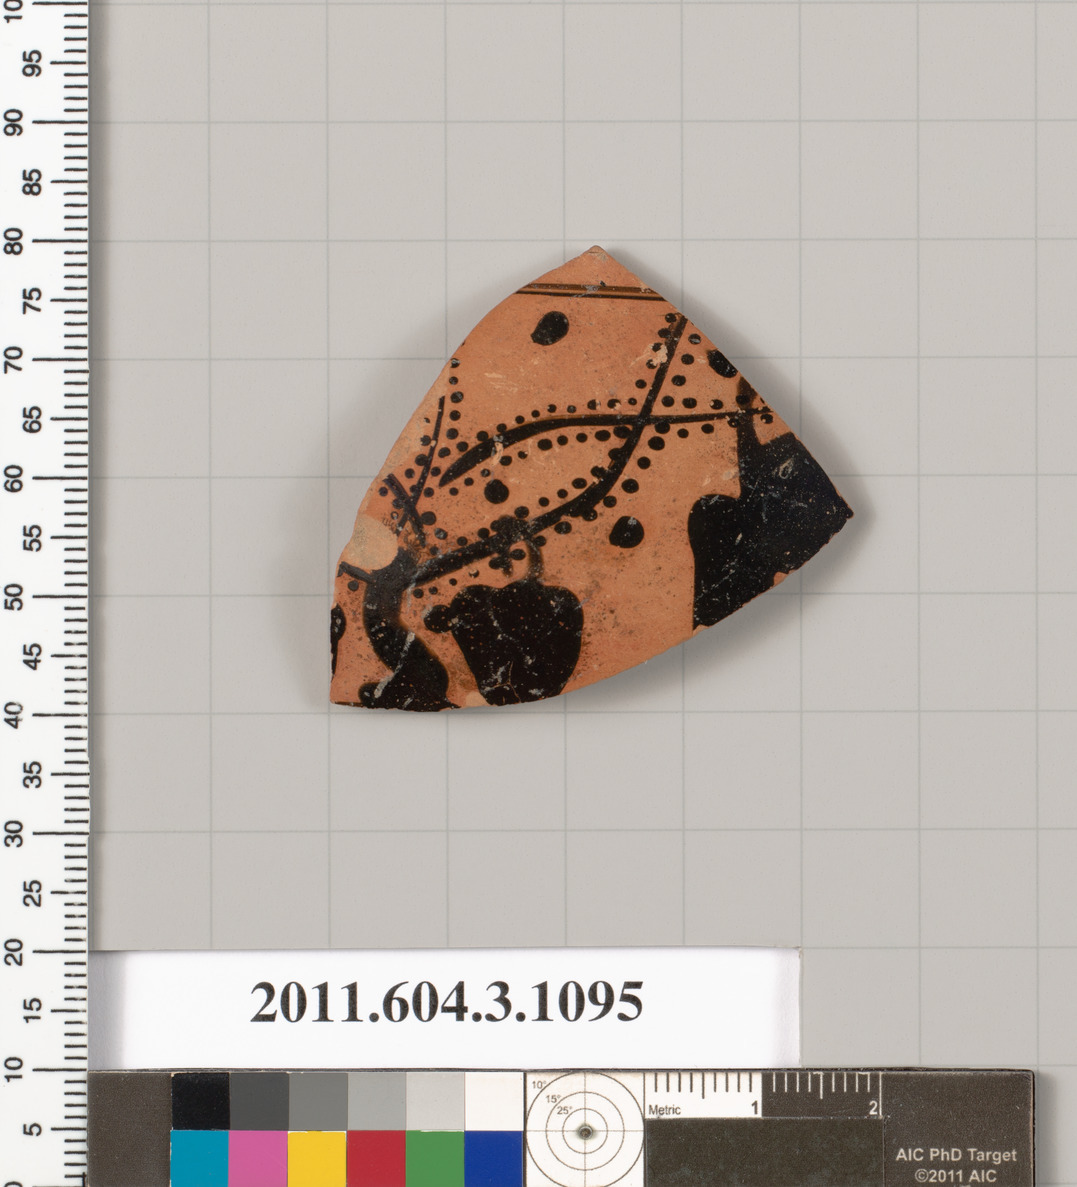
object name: mastoid fragment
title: Terracotta fragment of a mastoid (drinking cup with narrow base)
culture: greek, attic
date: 534-468 BCE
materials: terracotta